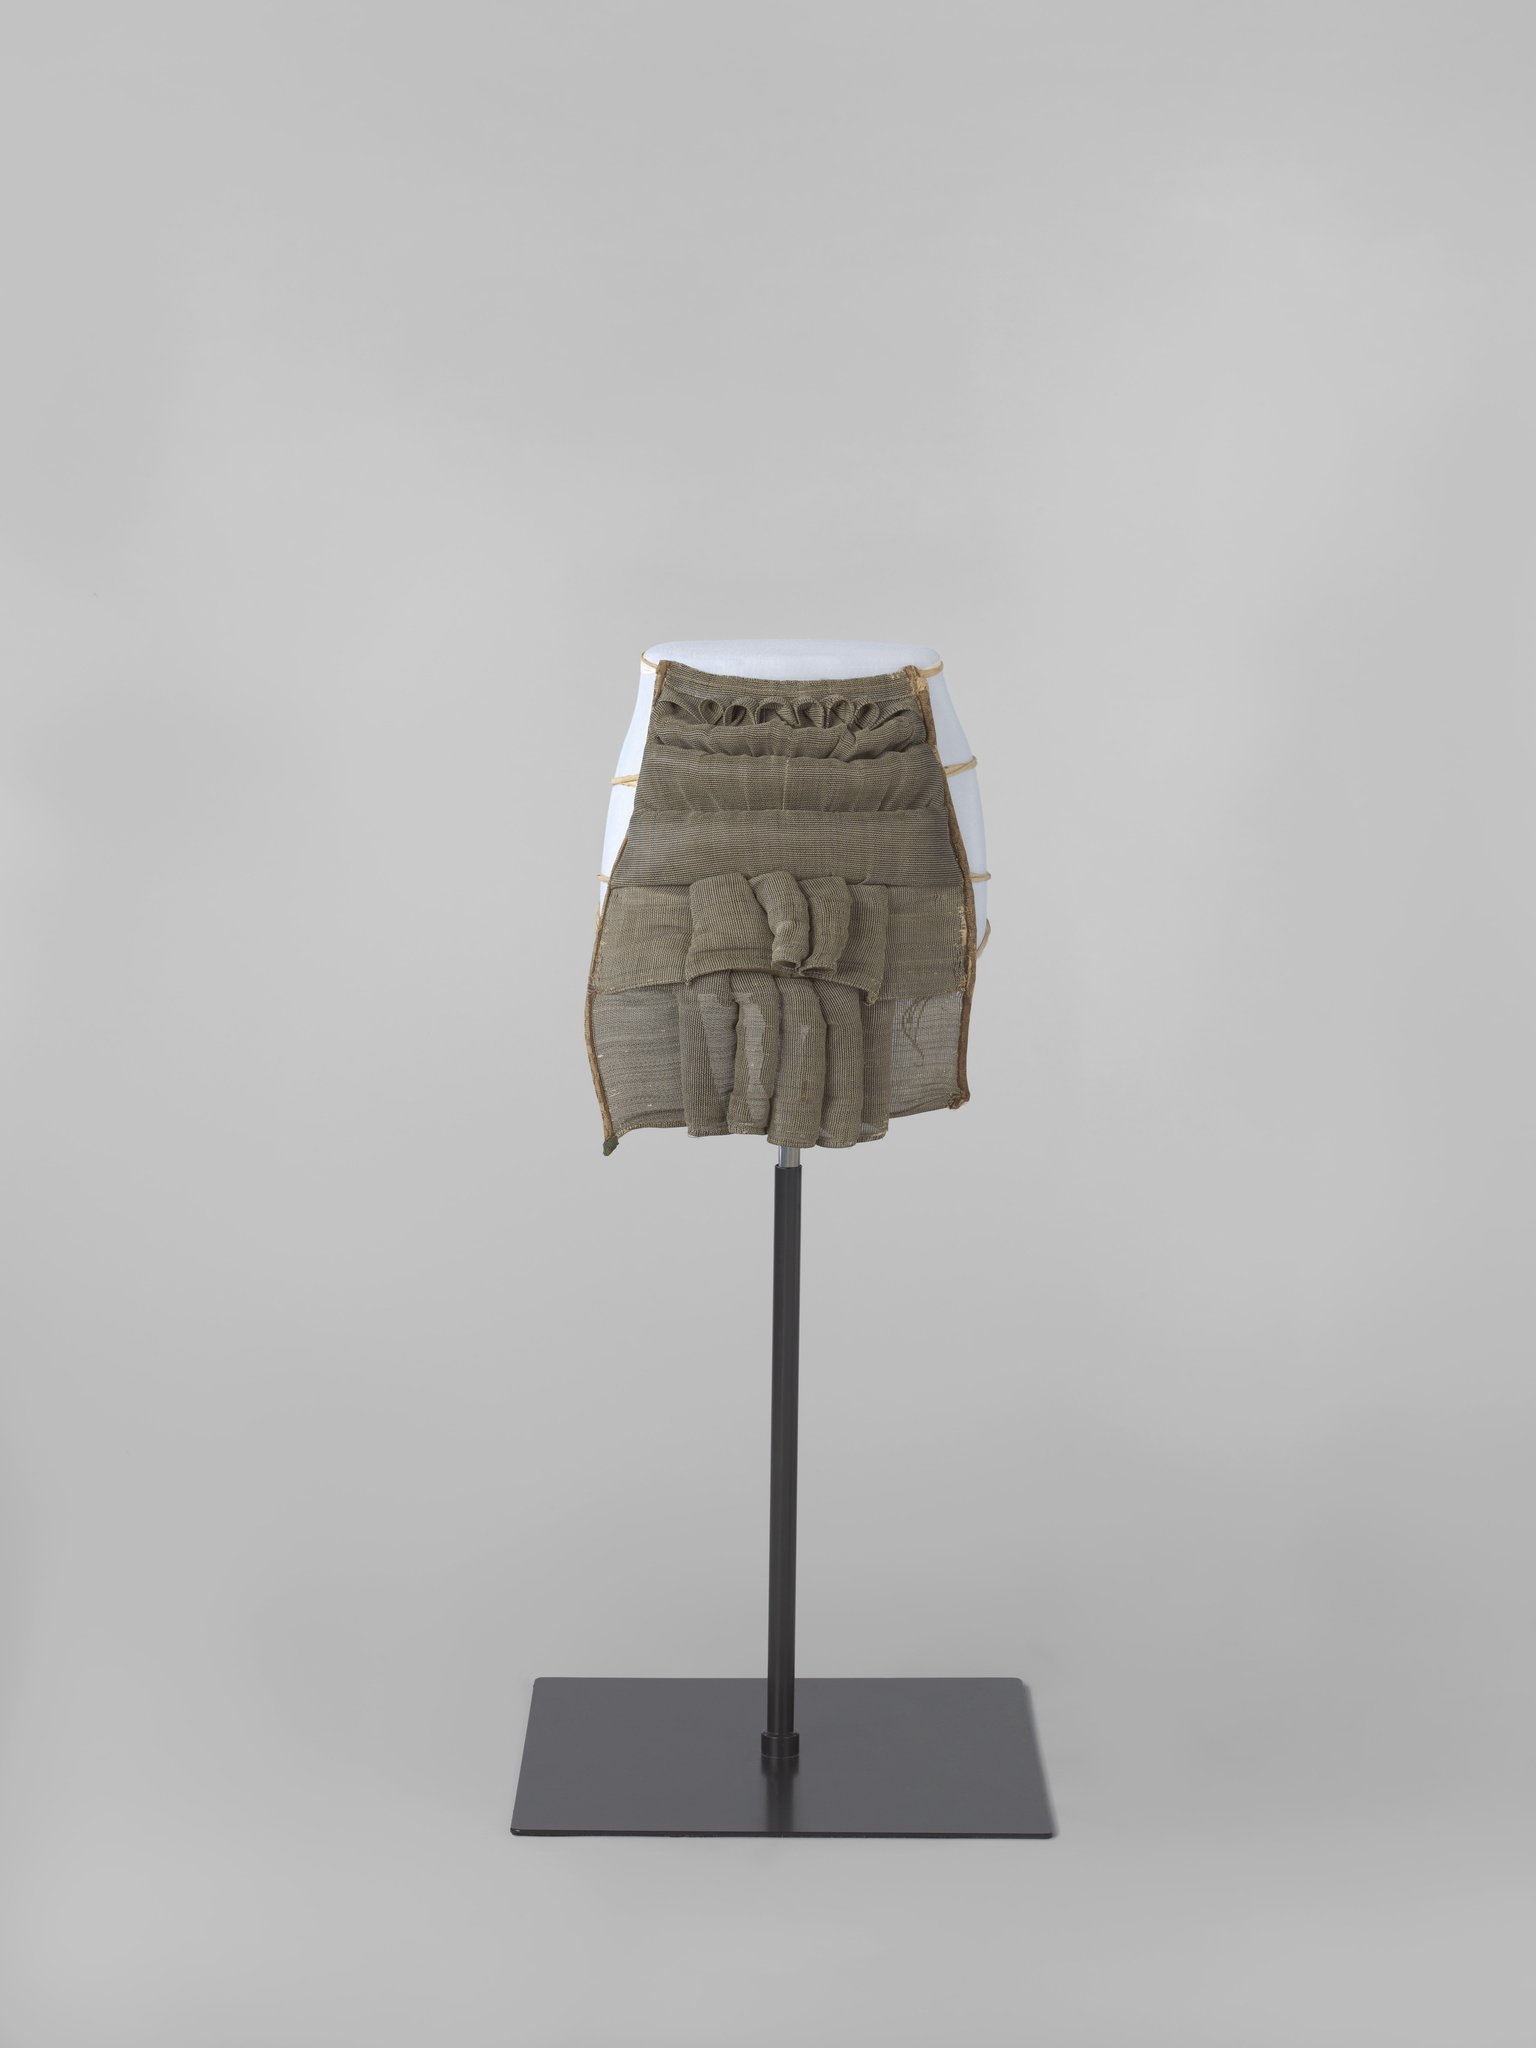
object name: underwear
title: Tournure van zwart-wit gestreept paardenhaar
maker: Anonymous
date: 1875-1900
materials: cotton, textile, linen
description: Tournure van gaas met witte en zwarte strepen, gedeeltelijk gevoerd met witte katoen en voorzien van twee ijzeren baleinen en tien linnen banden. Het gaas is in grote plooien in horizontale en verticale richting gelegd.